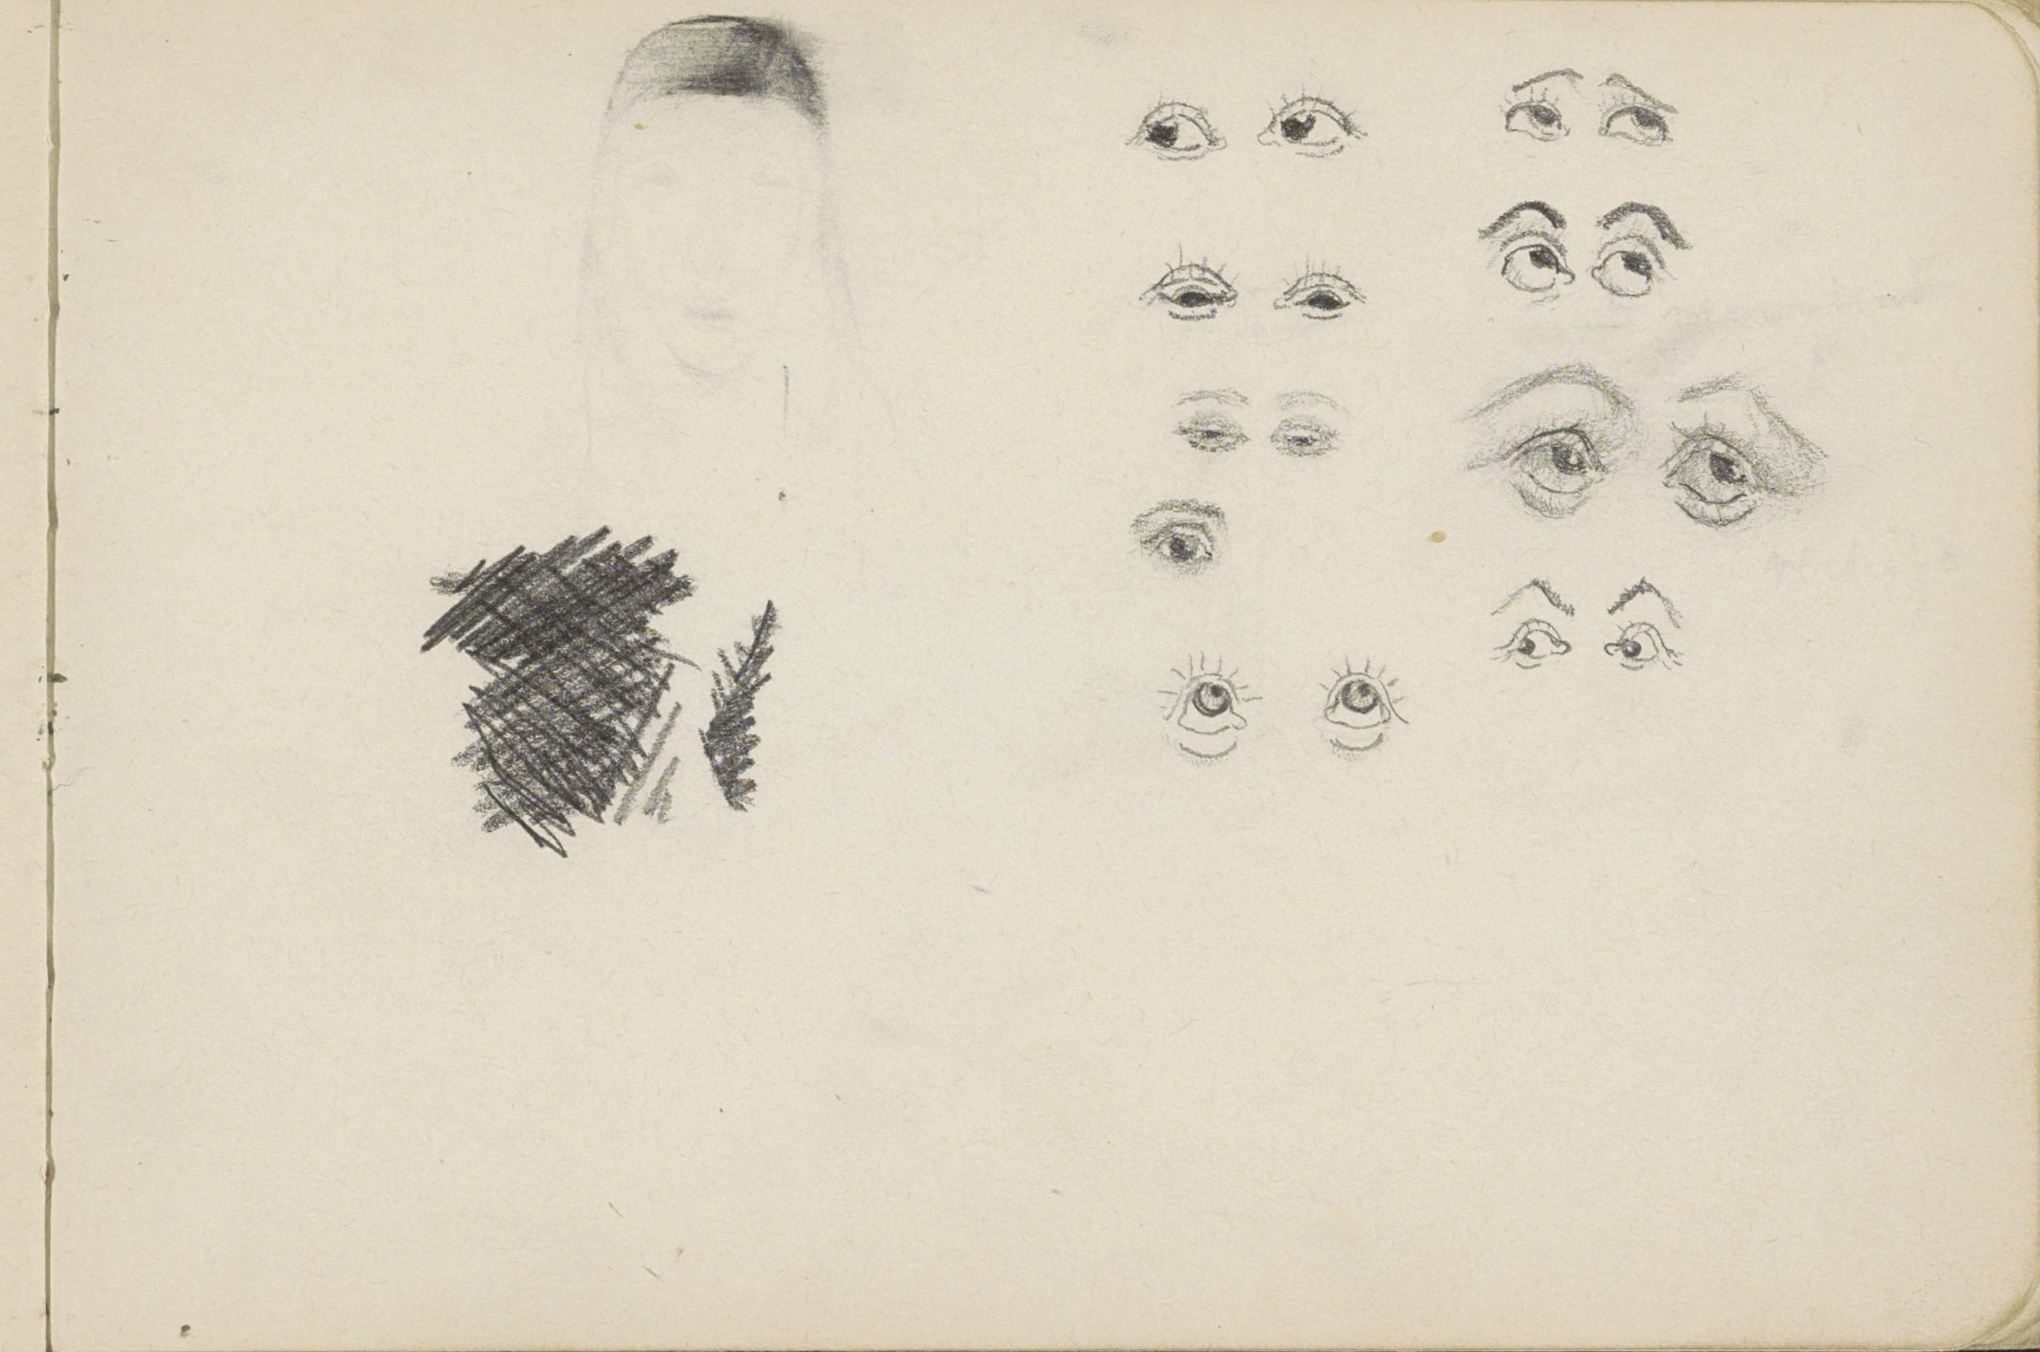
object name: sketchbook leaf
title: Ogen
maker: julie de graag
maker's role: draughtsman, print maker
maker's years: 1877-1924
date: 1894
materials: paper, pencil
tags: eyes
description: Blad 7 recto uit een schetsboek met 35 bladen.